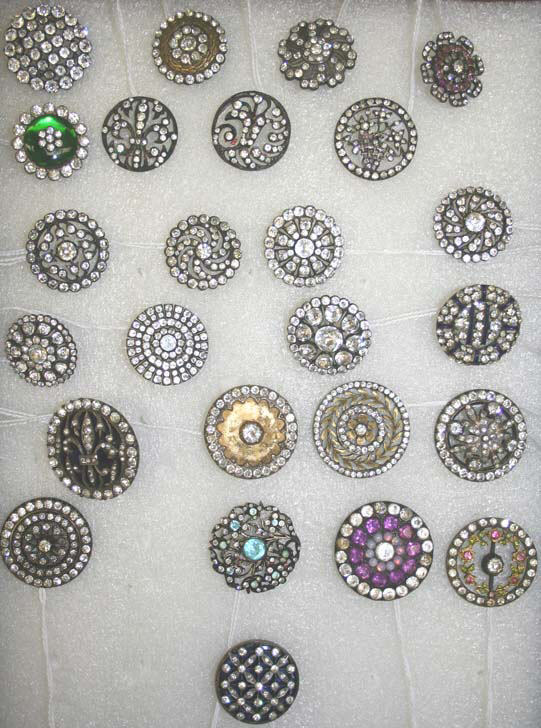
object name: button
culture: french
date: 1775-1820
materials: metal, paste